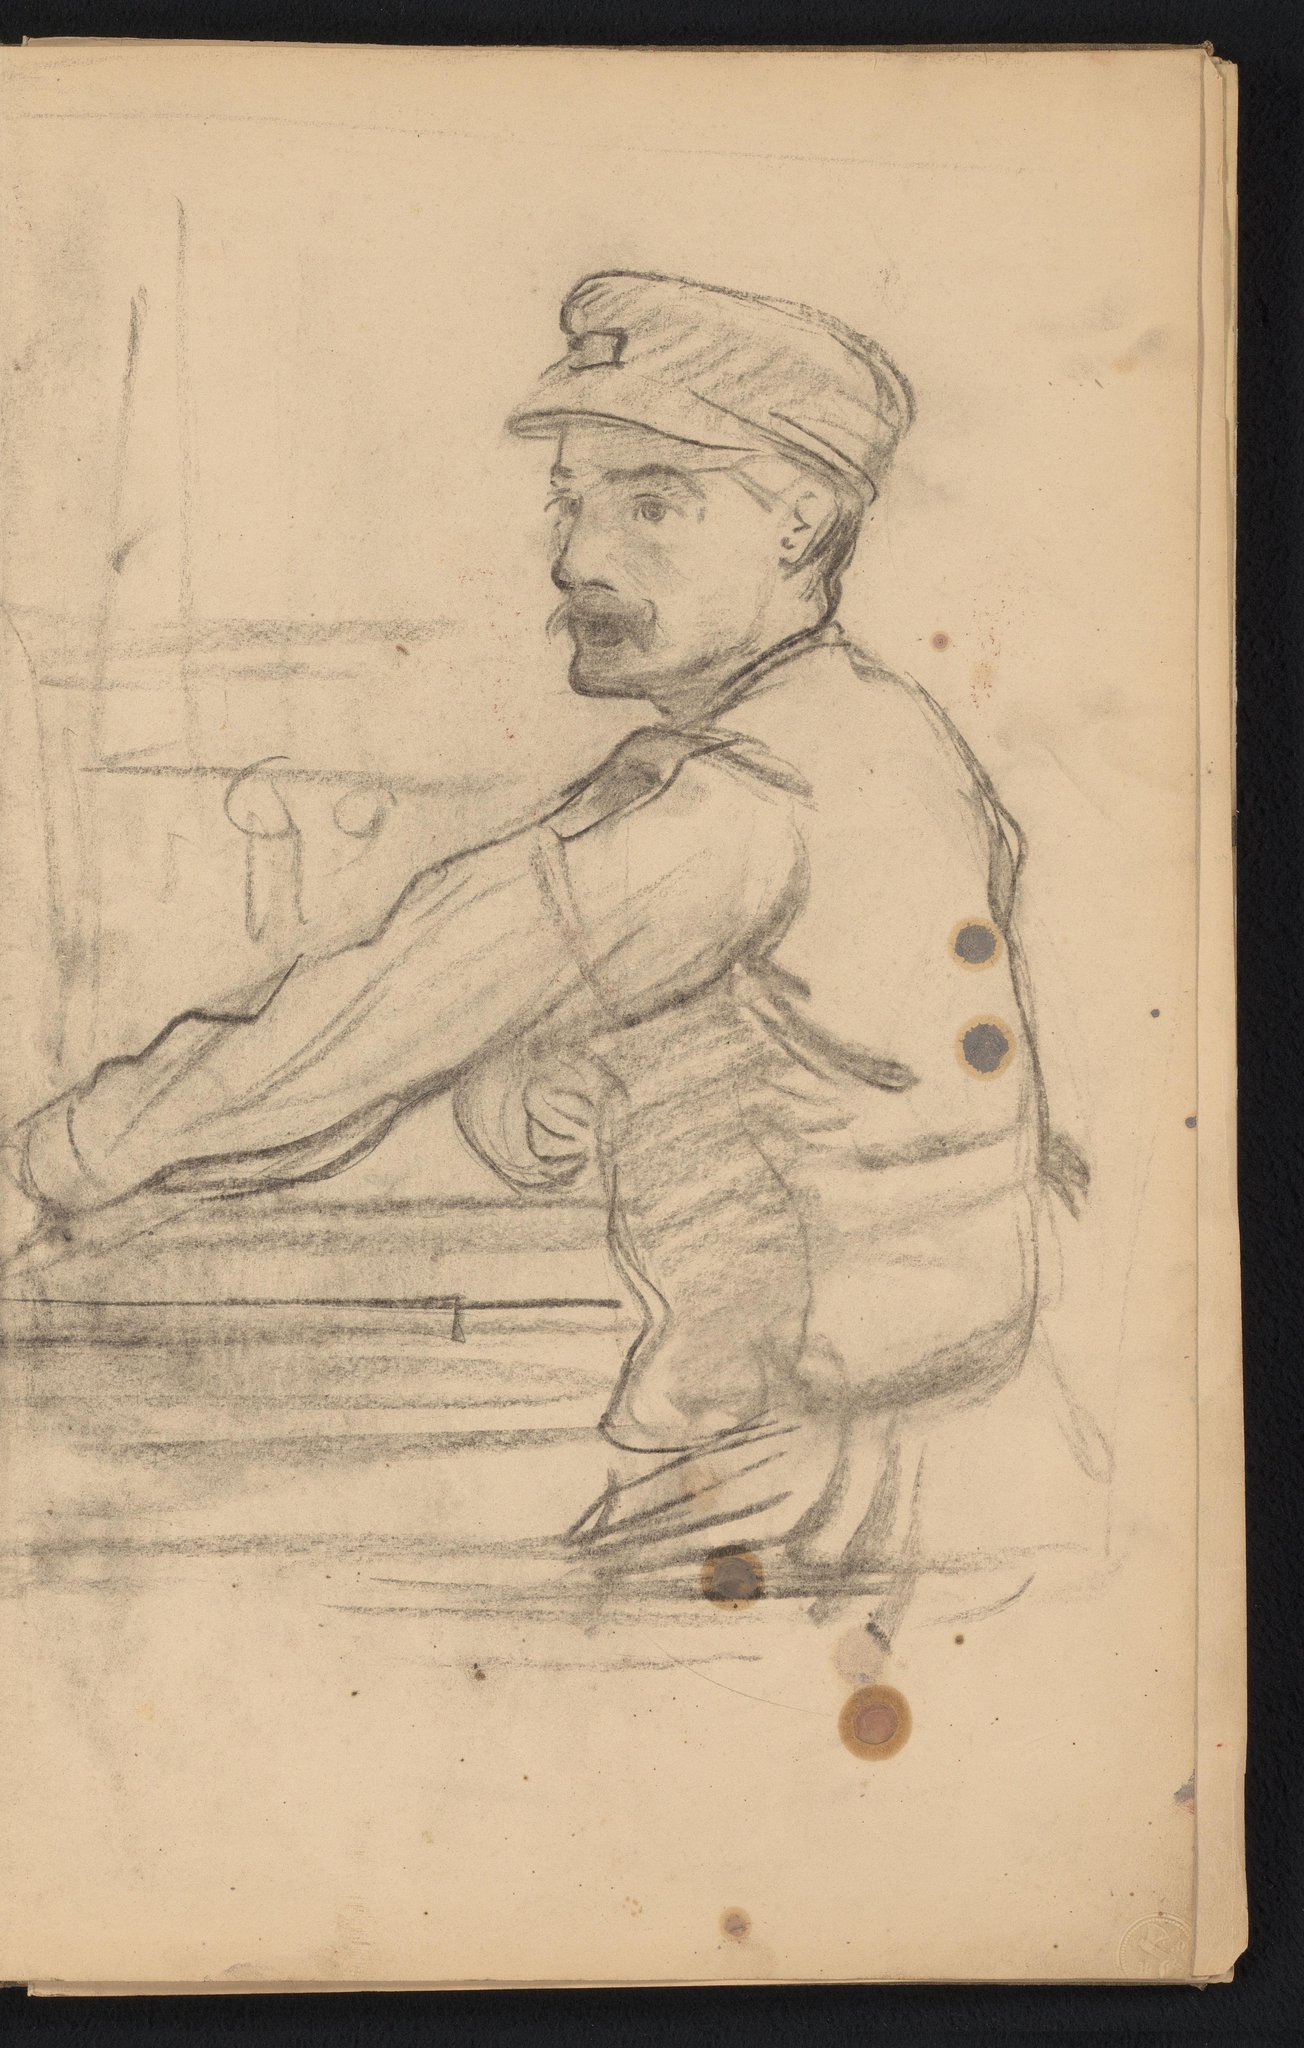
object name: sketchbook leaf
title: Man met een pet staand bij een tafel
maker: huib luns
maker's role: draughtsman, print maker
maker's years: 1881-1942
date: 1908-1909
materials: charcoal, paper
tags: standing figure, head-gear: cap (+ men's clothes), table, paper (writing material)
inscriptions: check stamp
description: Op de tafel ligt een rol papier die de man met zijn linkerhand vasthoudt. Blad 11 verso 12 recto uit een schetsboek met 24 bladen.